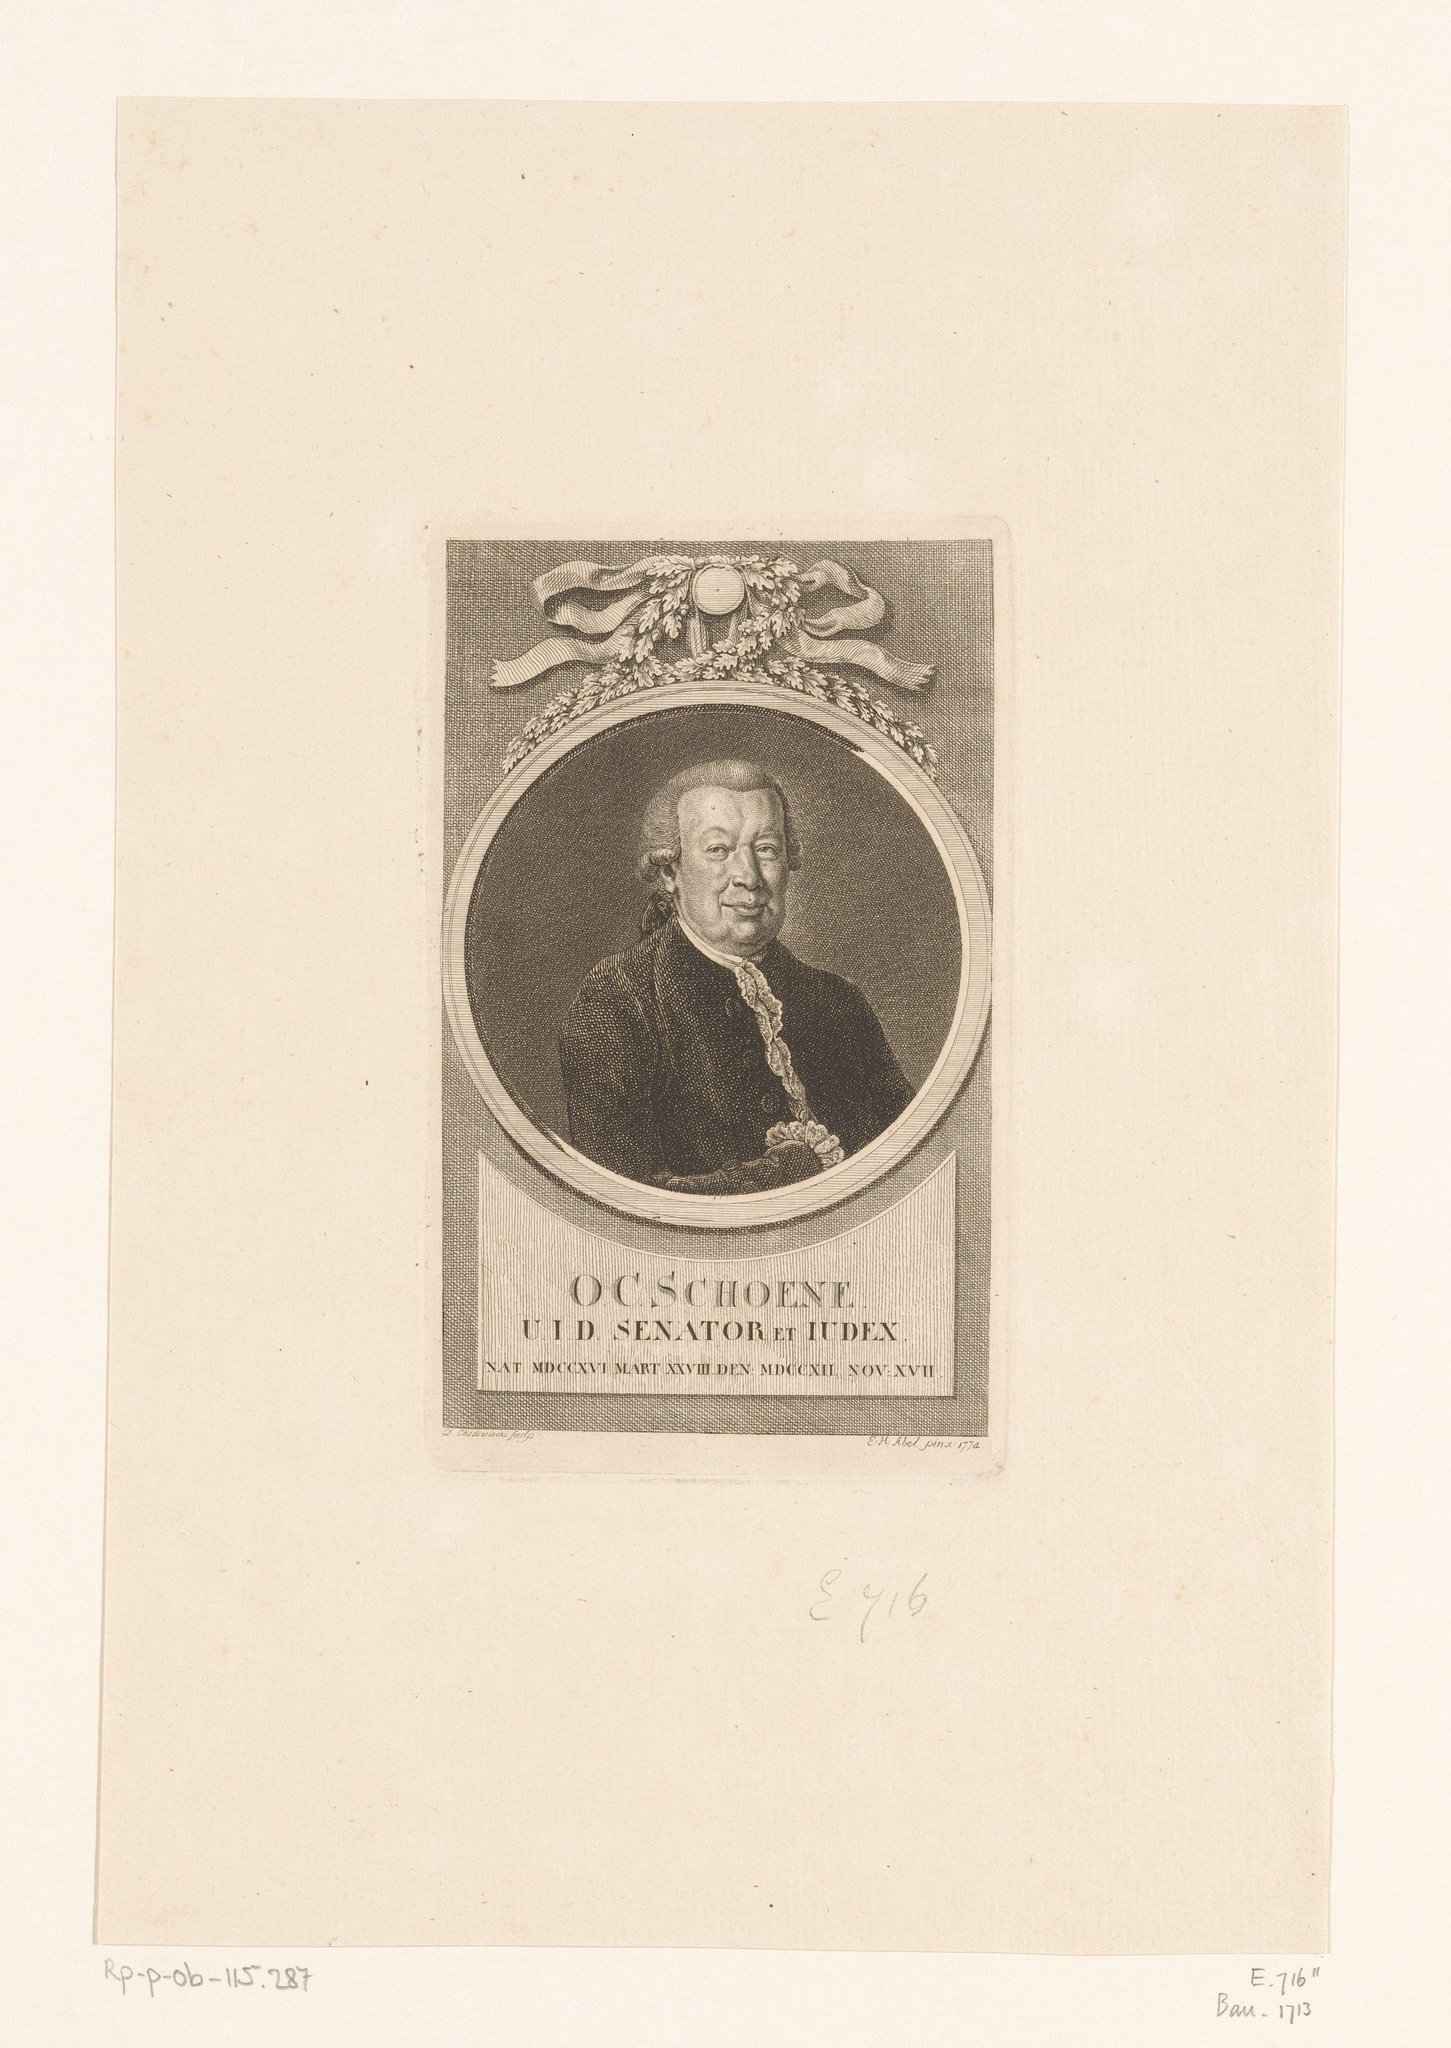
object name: print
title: Portret van Otto Christian Schoene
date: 1793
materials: paper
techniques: etching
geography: berlin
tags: garland, wreath, ornament ~ medallion, historical persons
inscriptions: collector's mark: Lugt 2228